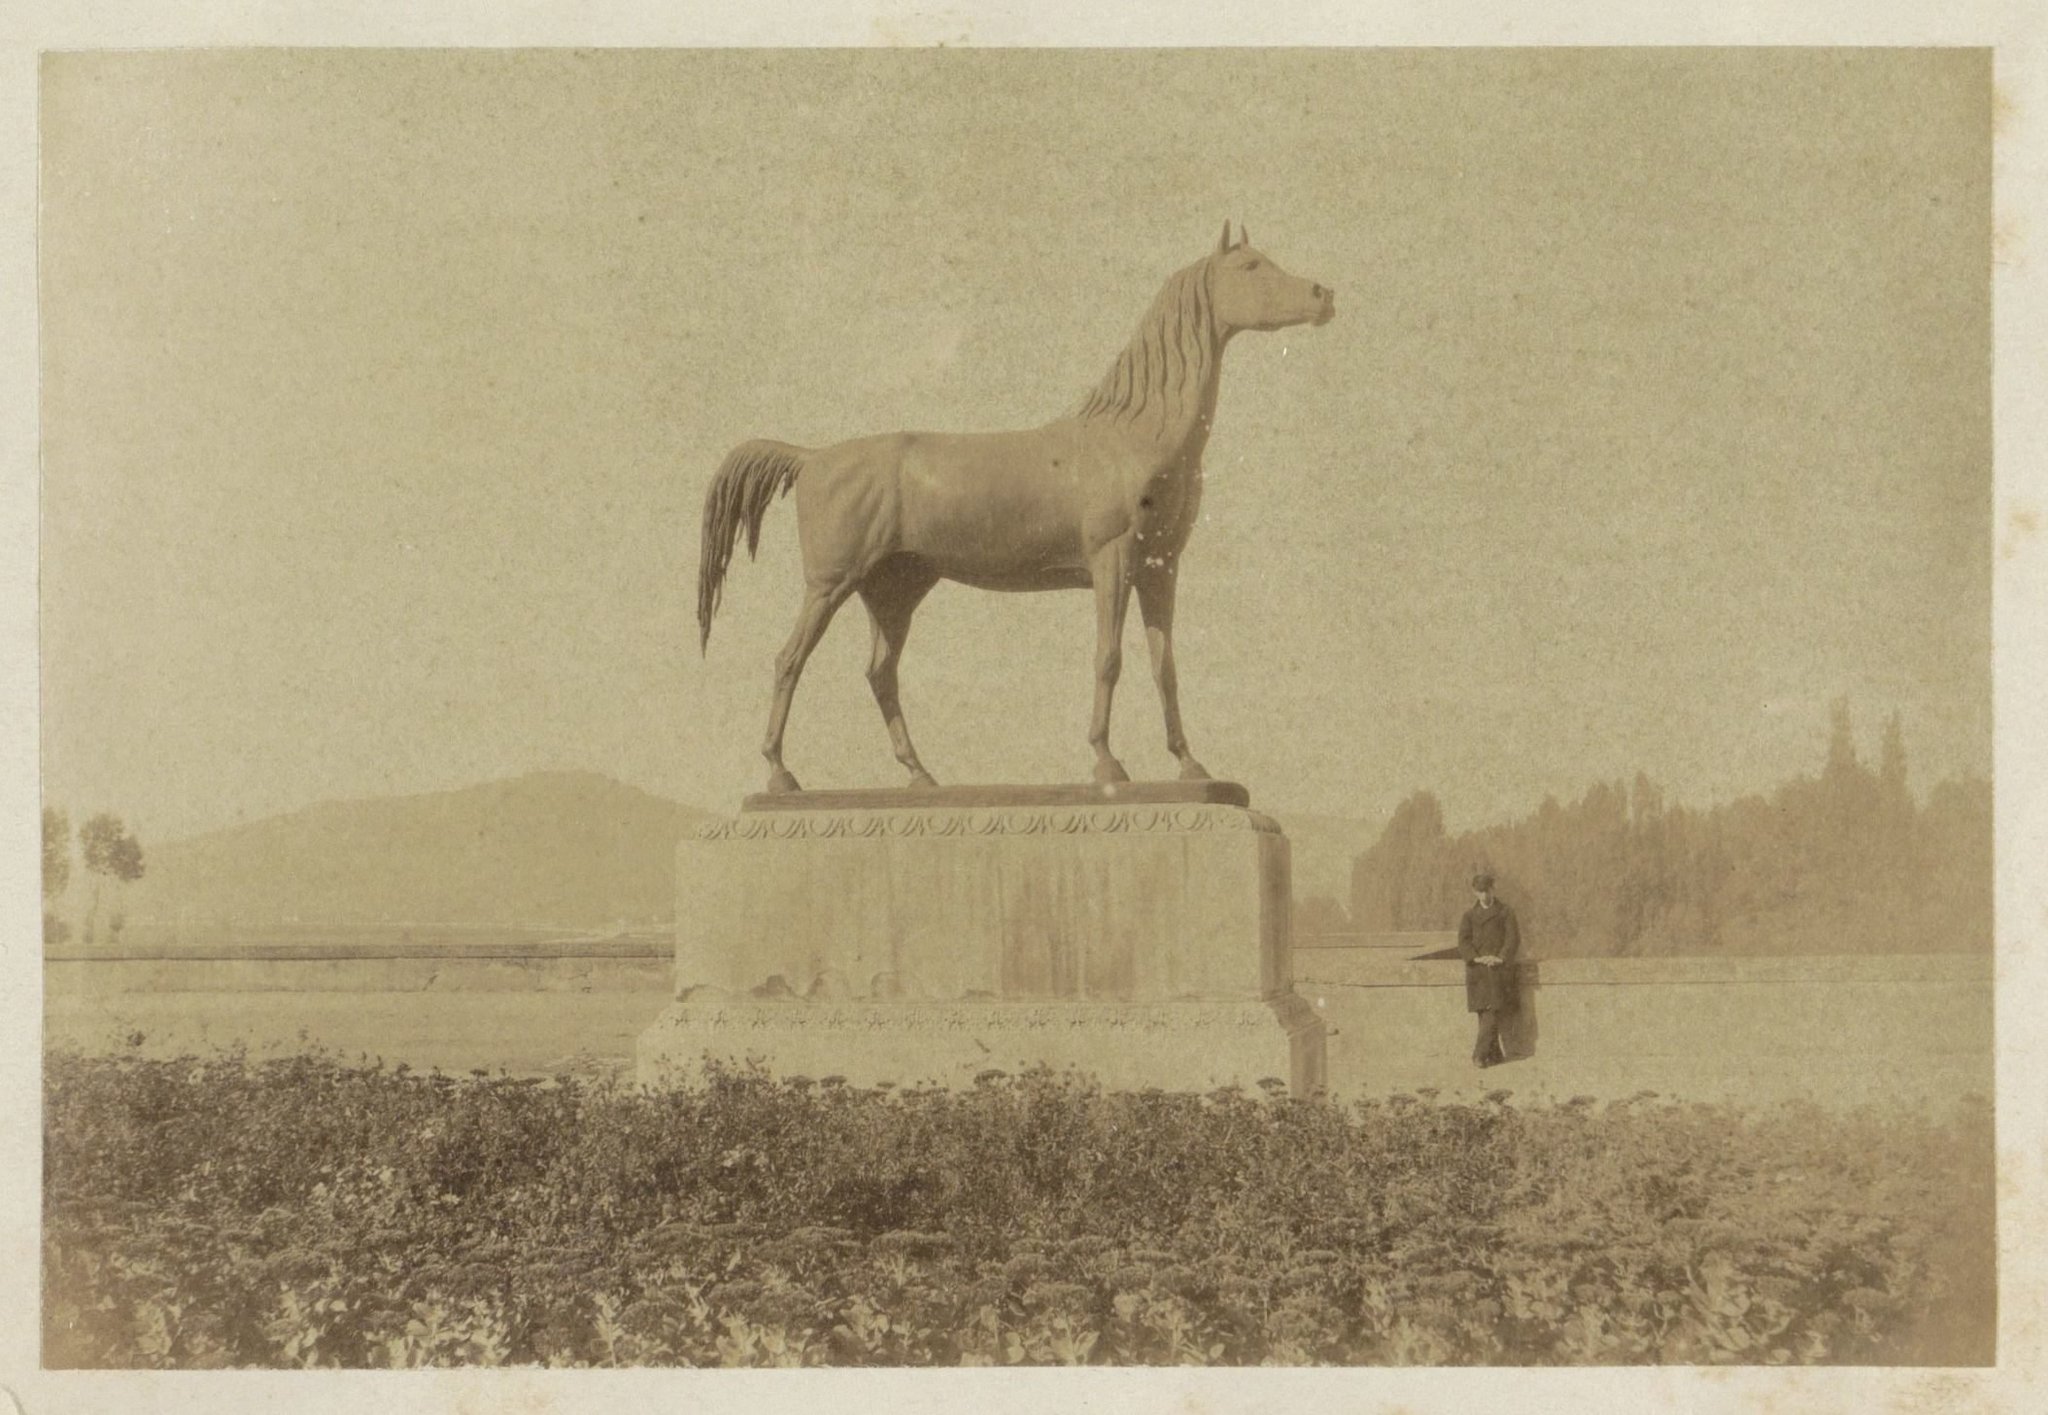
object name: photograph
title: Man poserend bij een beeld van een paard, vermoedelijk in Frankrijk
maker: Anonymous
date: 1883-1886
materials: photographic support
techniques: albumen print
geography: france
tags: piece of sculpture, reproduction of a piece of sculpture, france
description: Onderdeel van Album van een Franse amateurfotograaf met opnames van familie, militairen, industrie, landschappen en bezienswaardigheden in Frankrijk.